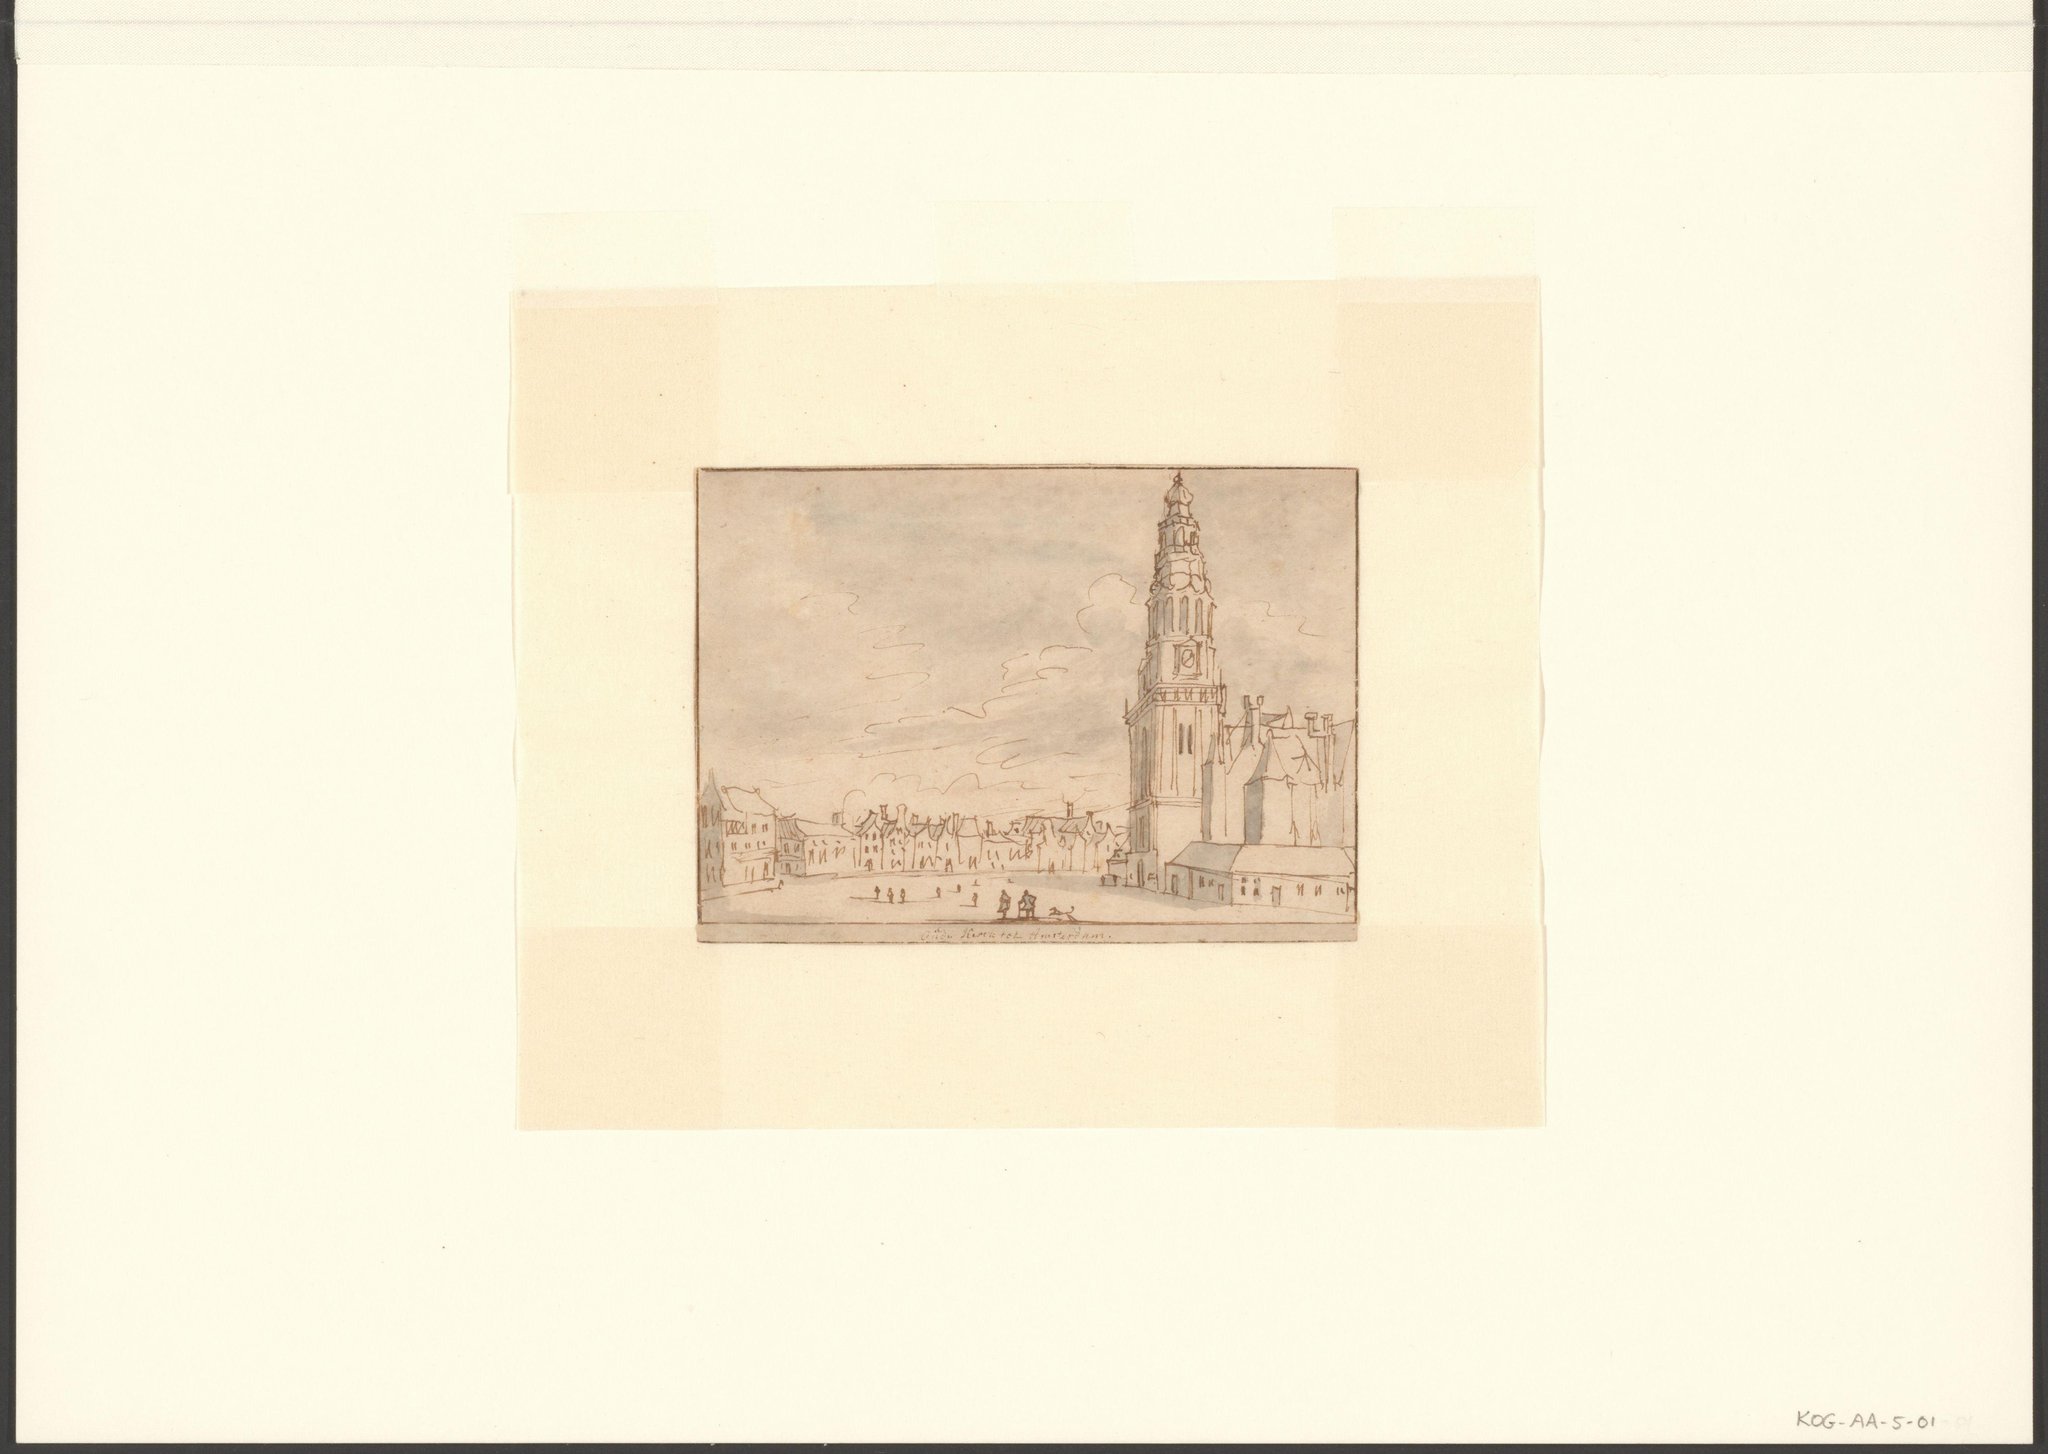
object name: drawing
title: Gezicht op de Oude Kerk te Amsterdam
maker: jan luyken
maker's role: draughtsman, print maker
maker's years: 1649-1712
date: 1659-1712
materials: ink, paper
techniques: pen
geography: amsterdam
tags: city-view in general; 'veduta', church (exterior)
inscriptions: inscription: ‘oude kerk [...]’, inscription: ‘4’, inscription: ‘Oude Kerk tot Amsterdam.’